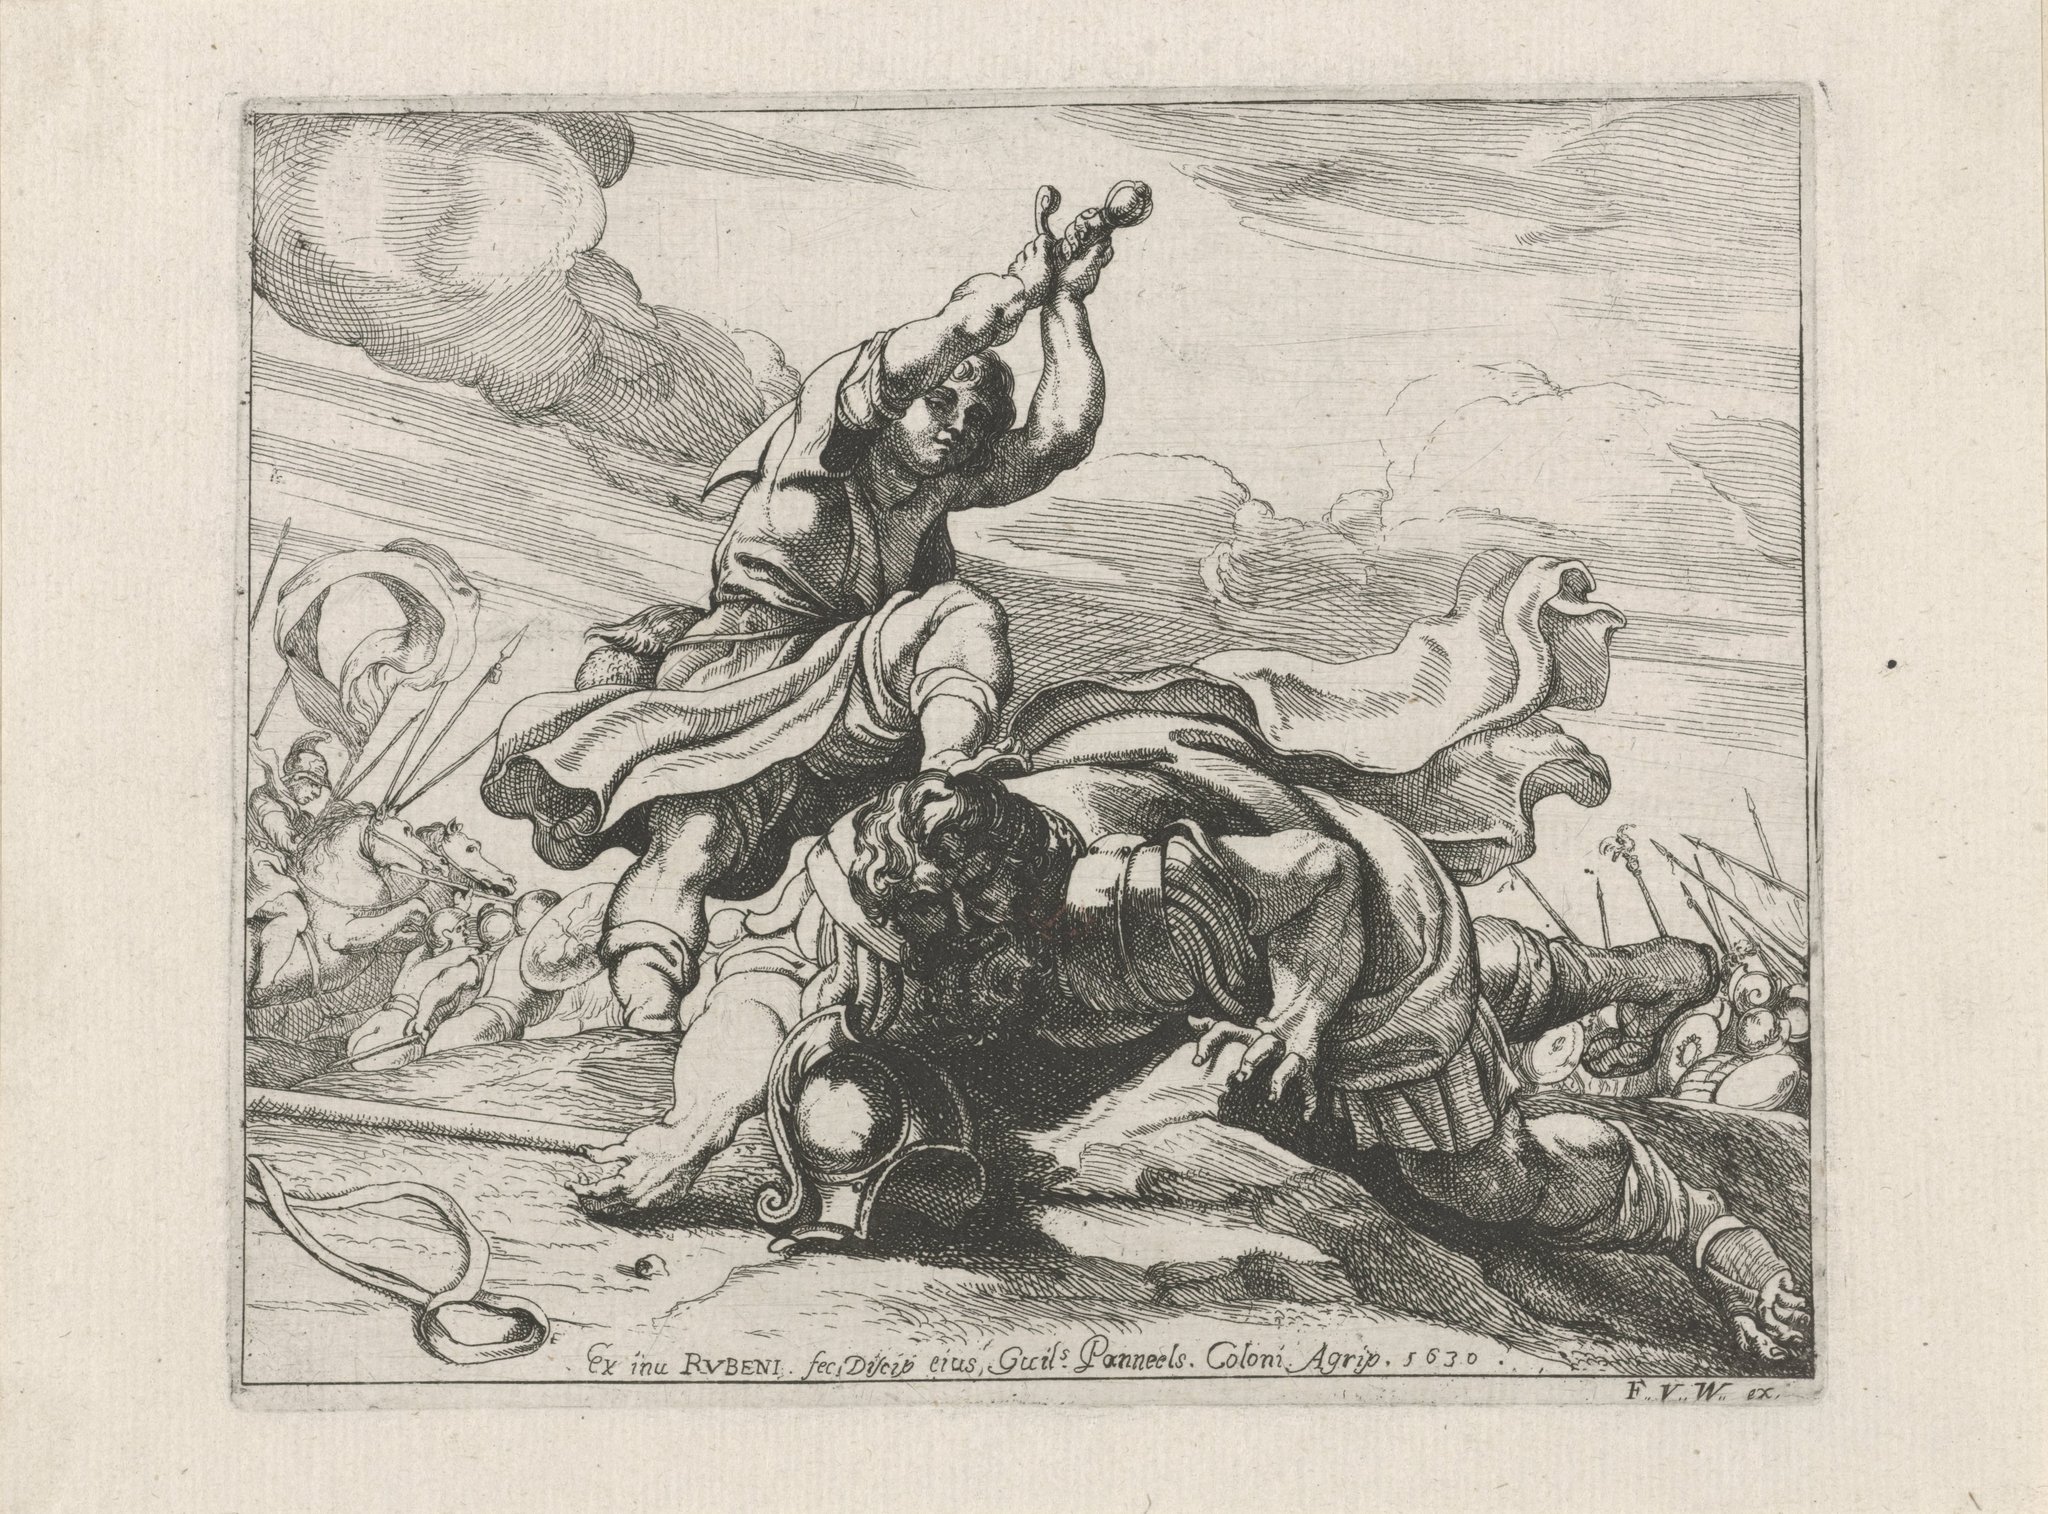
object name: print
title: David onthoofdt Goliath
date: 1630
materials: paper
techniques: engraving, etching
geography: cologne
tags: david beheads goliath with a sword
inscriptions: collector's mark: Lugt 240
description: Slagveld met de jonge David die op het punt staat om Goliath te onthoofden met zijn zwaard.